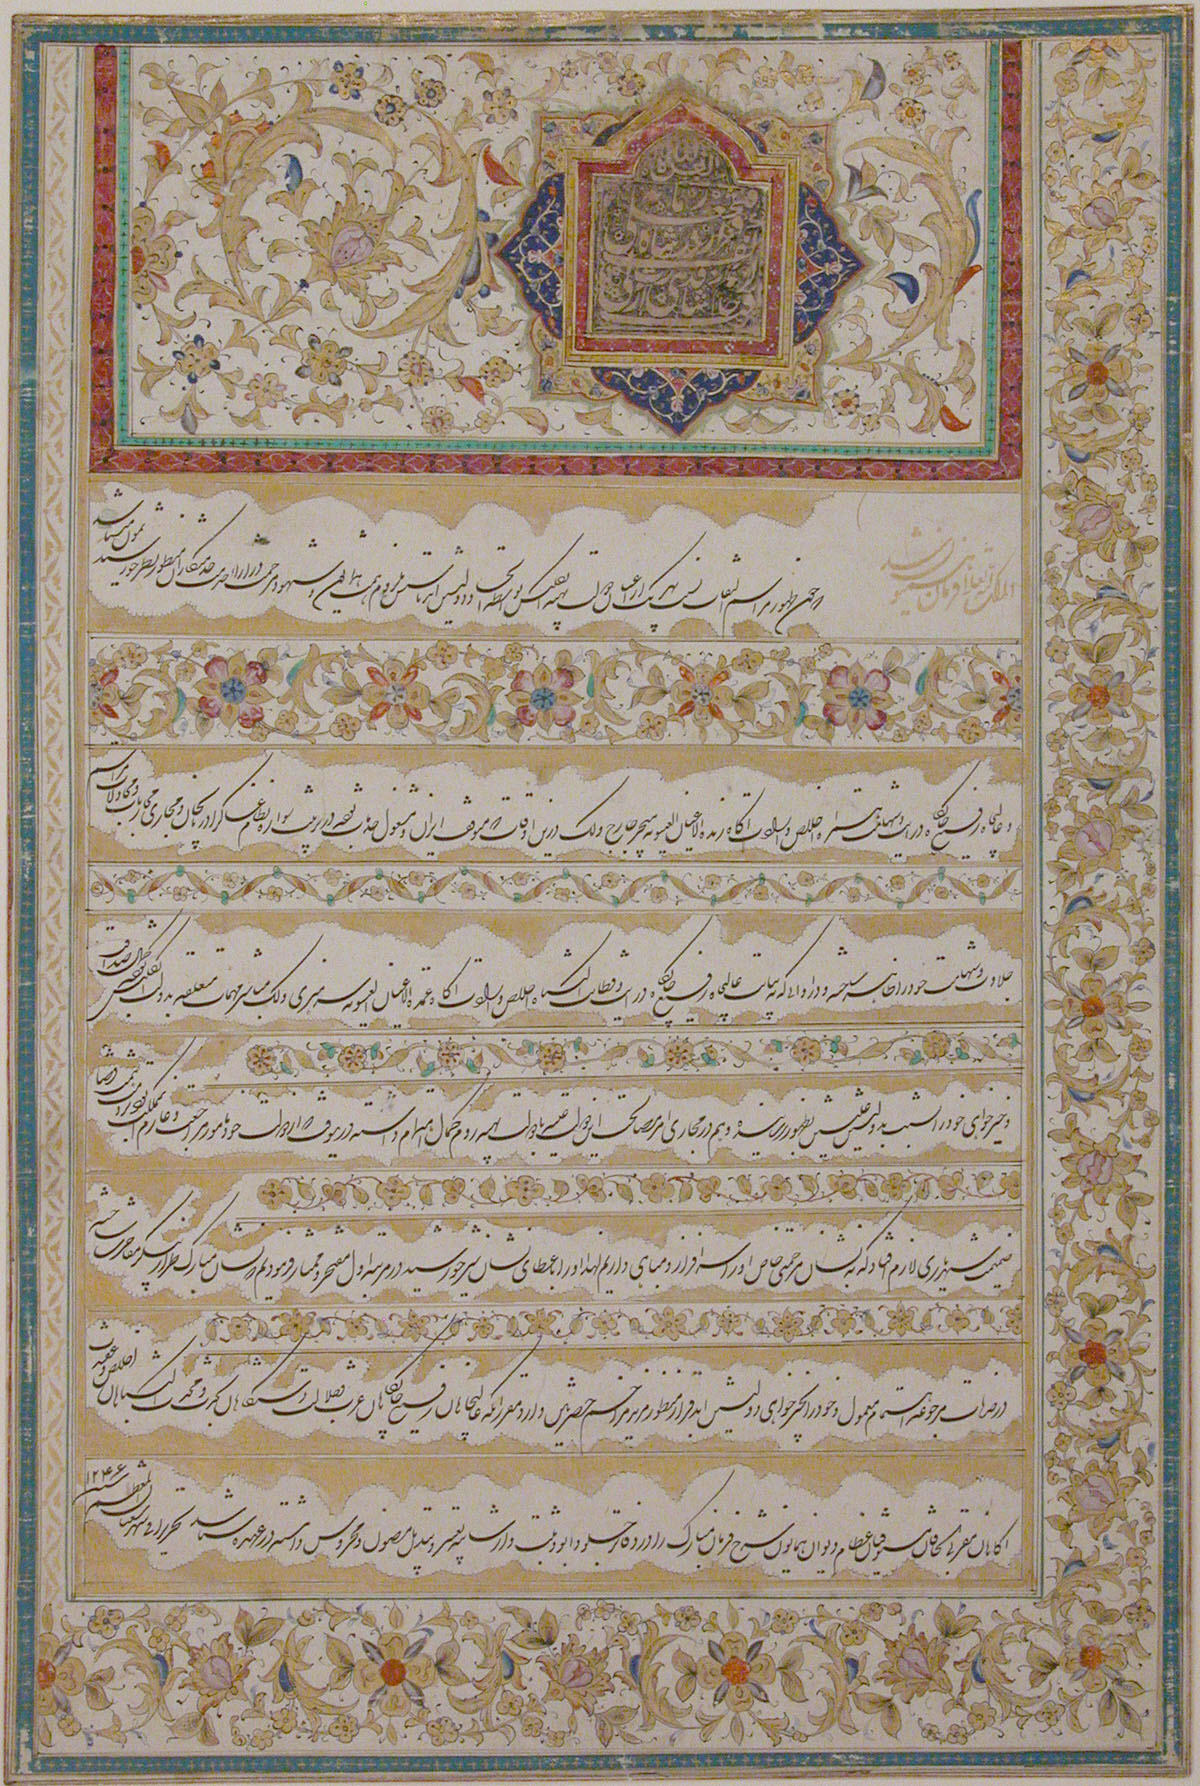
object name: firman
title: Firman Issued in the Name of Fath 'Ali Shah Qajar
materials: gold, ink, paper, watercolor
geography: iran